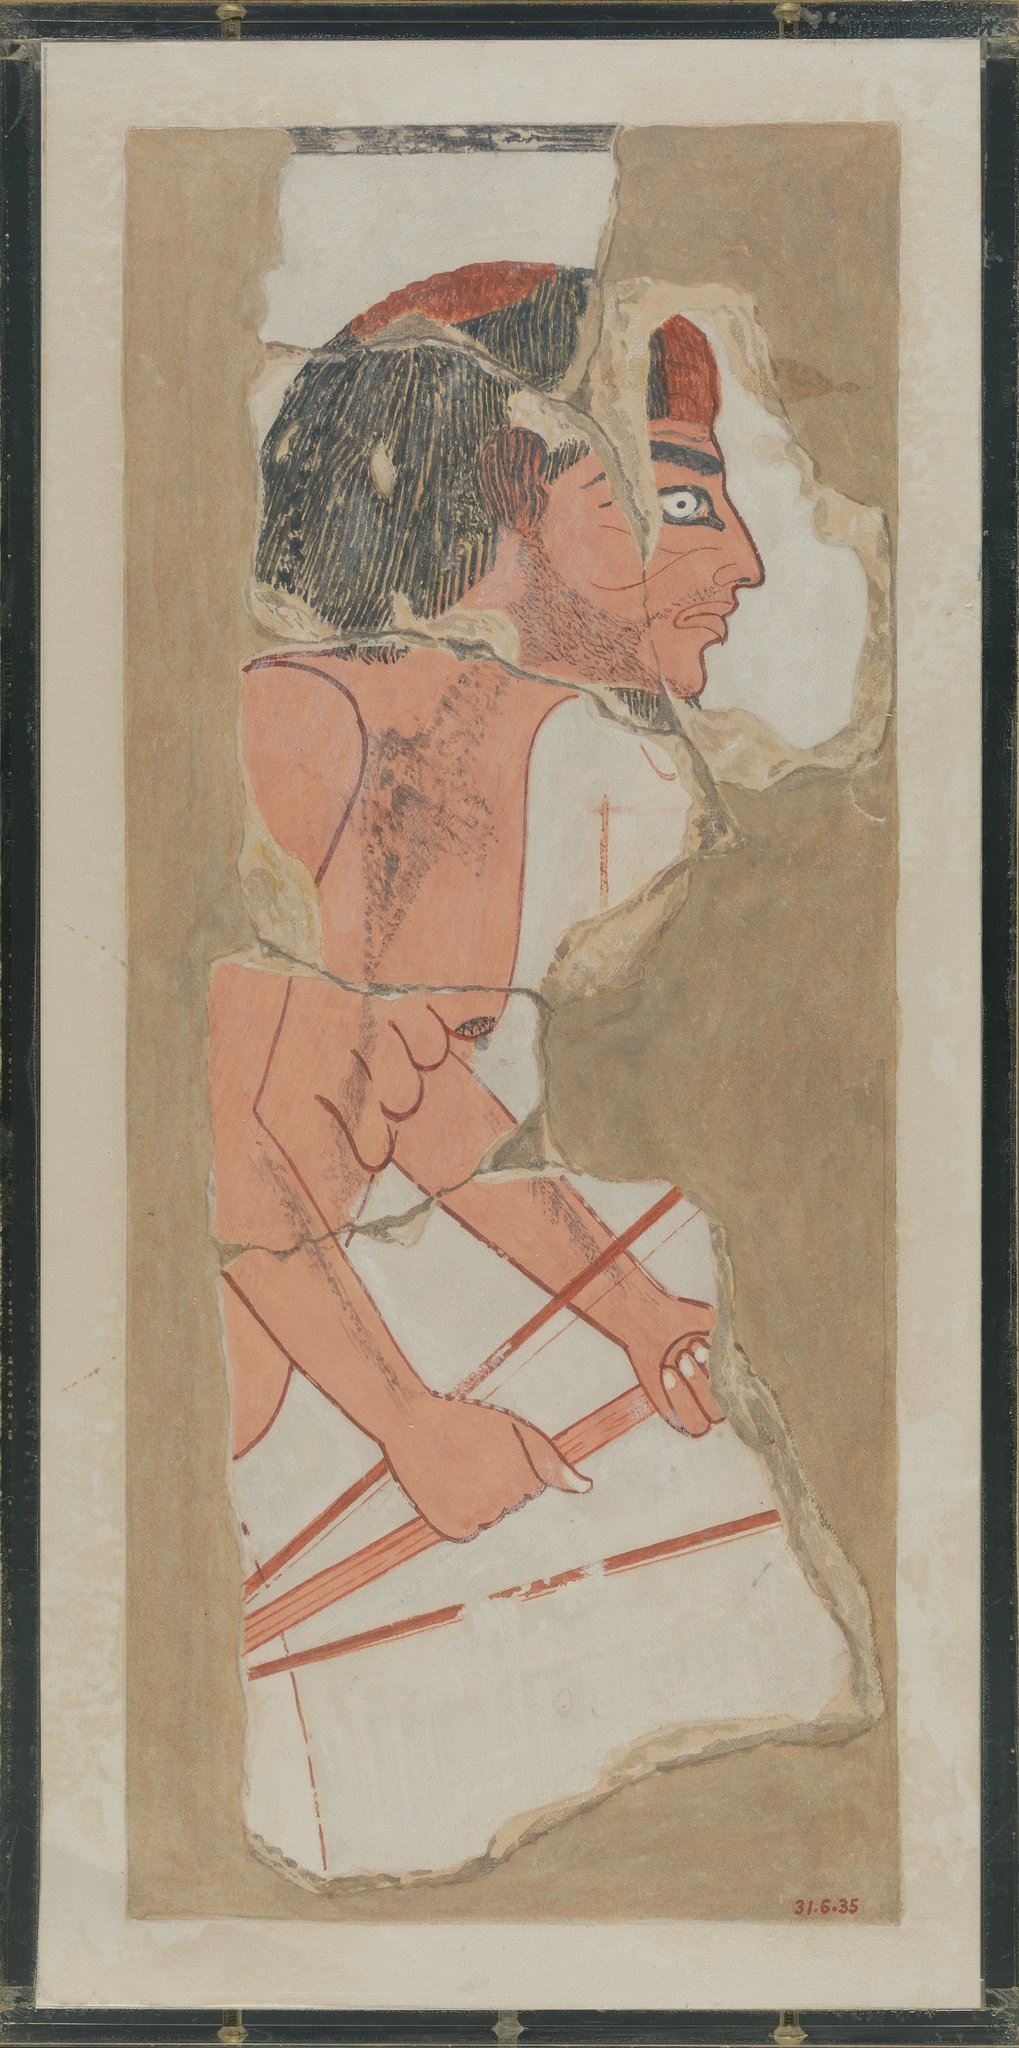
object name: facsimile, foreigner, intef tt155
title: Facsimile Painting of a Foreigner, Tomb of Intef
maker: nina de garis davies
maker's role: artist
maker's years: 1881-1965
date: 1479-1458 BCE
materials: paper, paint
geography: egypt